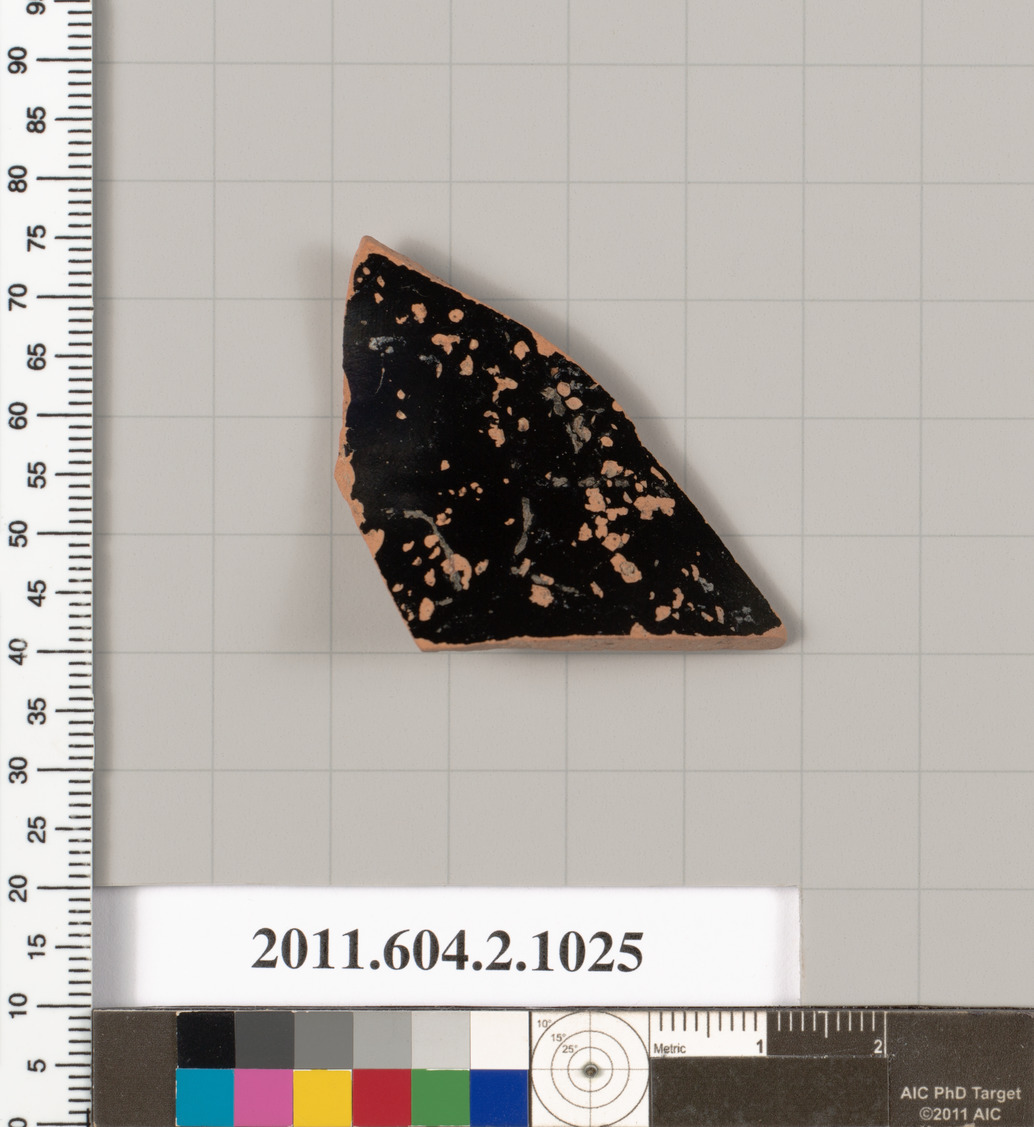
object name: oinochoe fragment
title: Terracotta fragment of an oinochoe (jug)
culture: greek, attic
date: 475-425 BCE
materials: terracotta